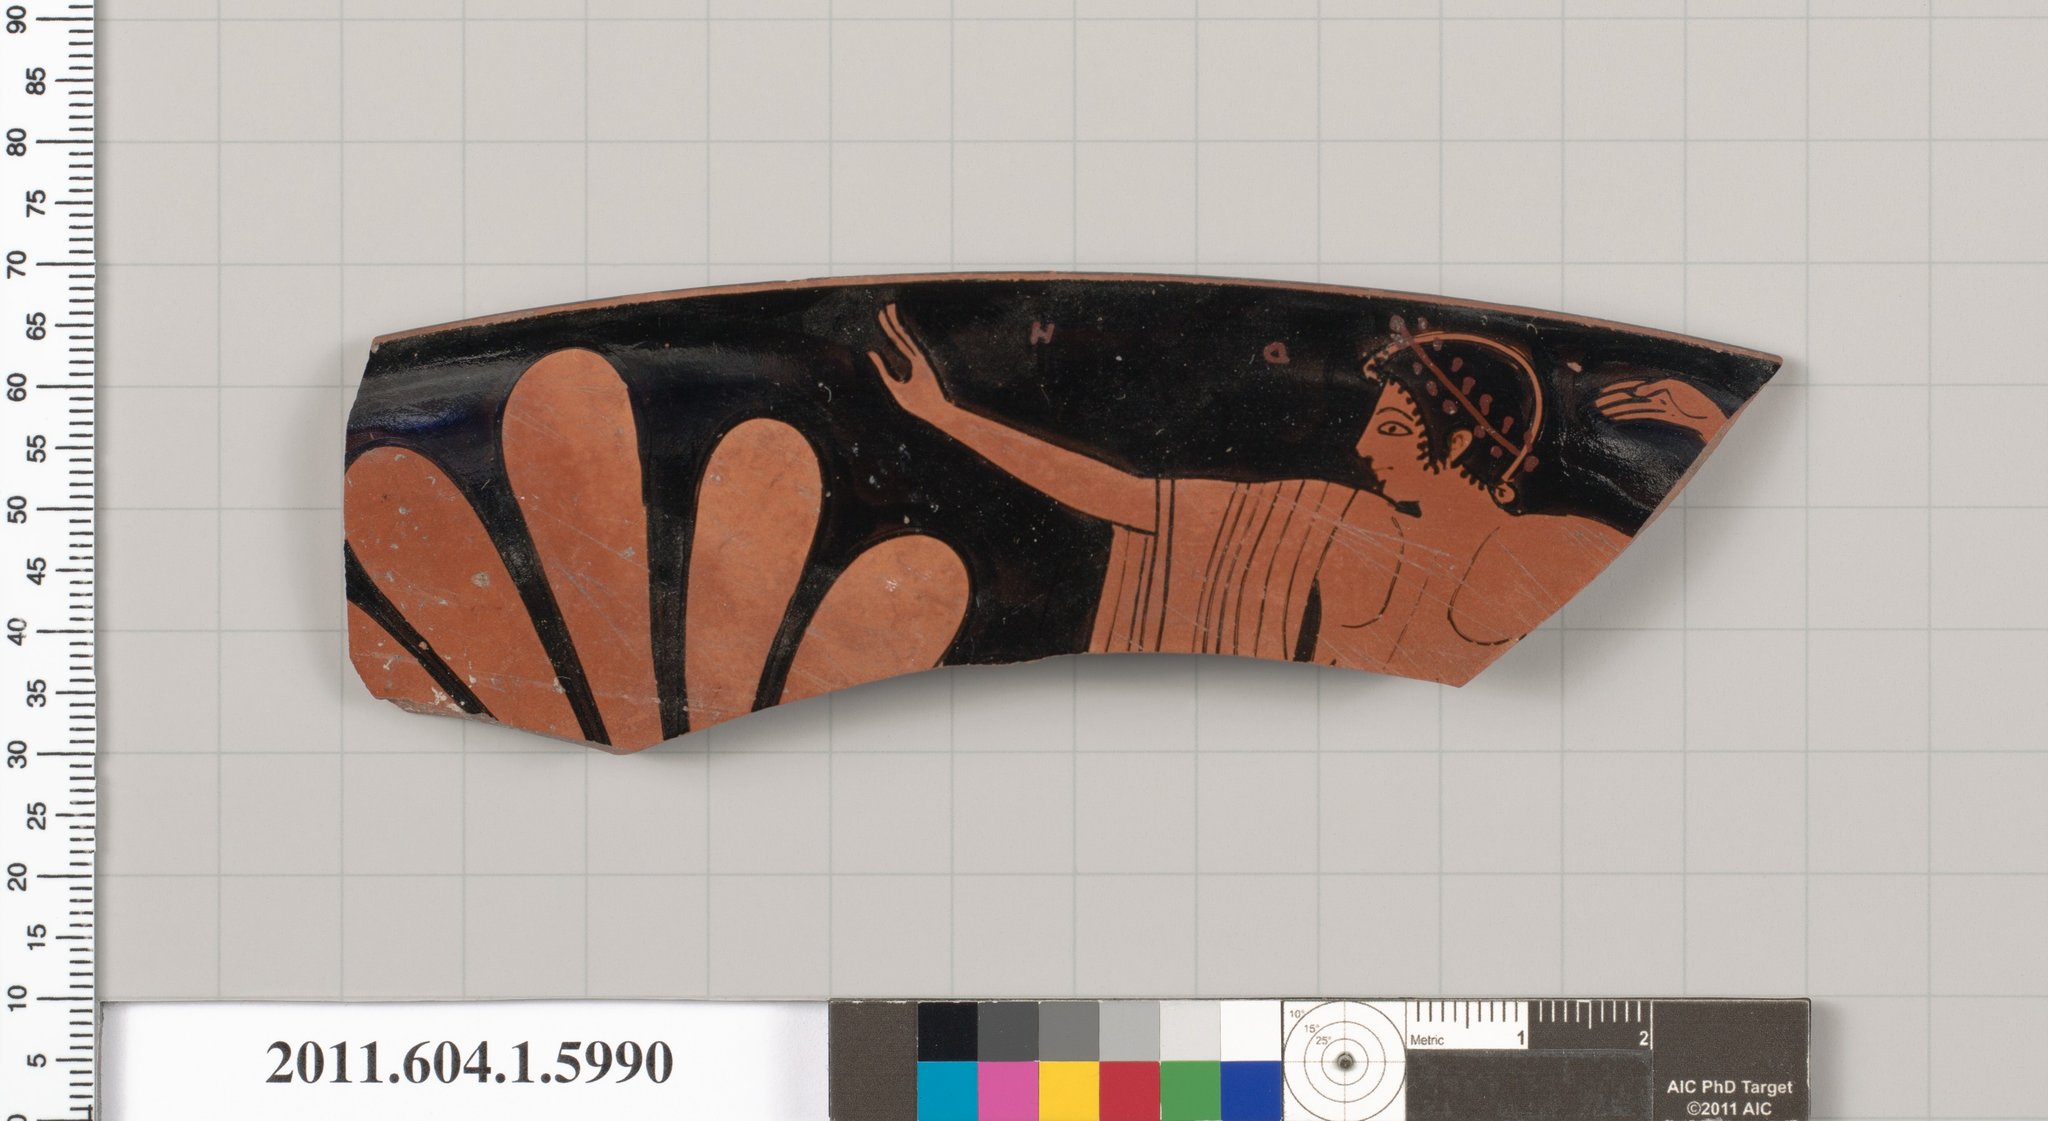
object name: kylix fragment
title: Terracotta rim fragment of a kylix (drinking cup)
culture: greek, attic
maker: euergides painter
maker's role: artist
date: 510-500 BCE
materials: terracotta